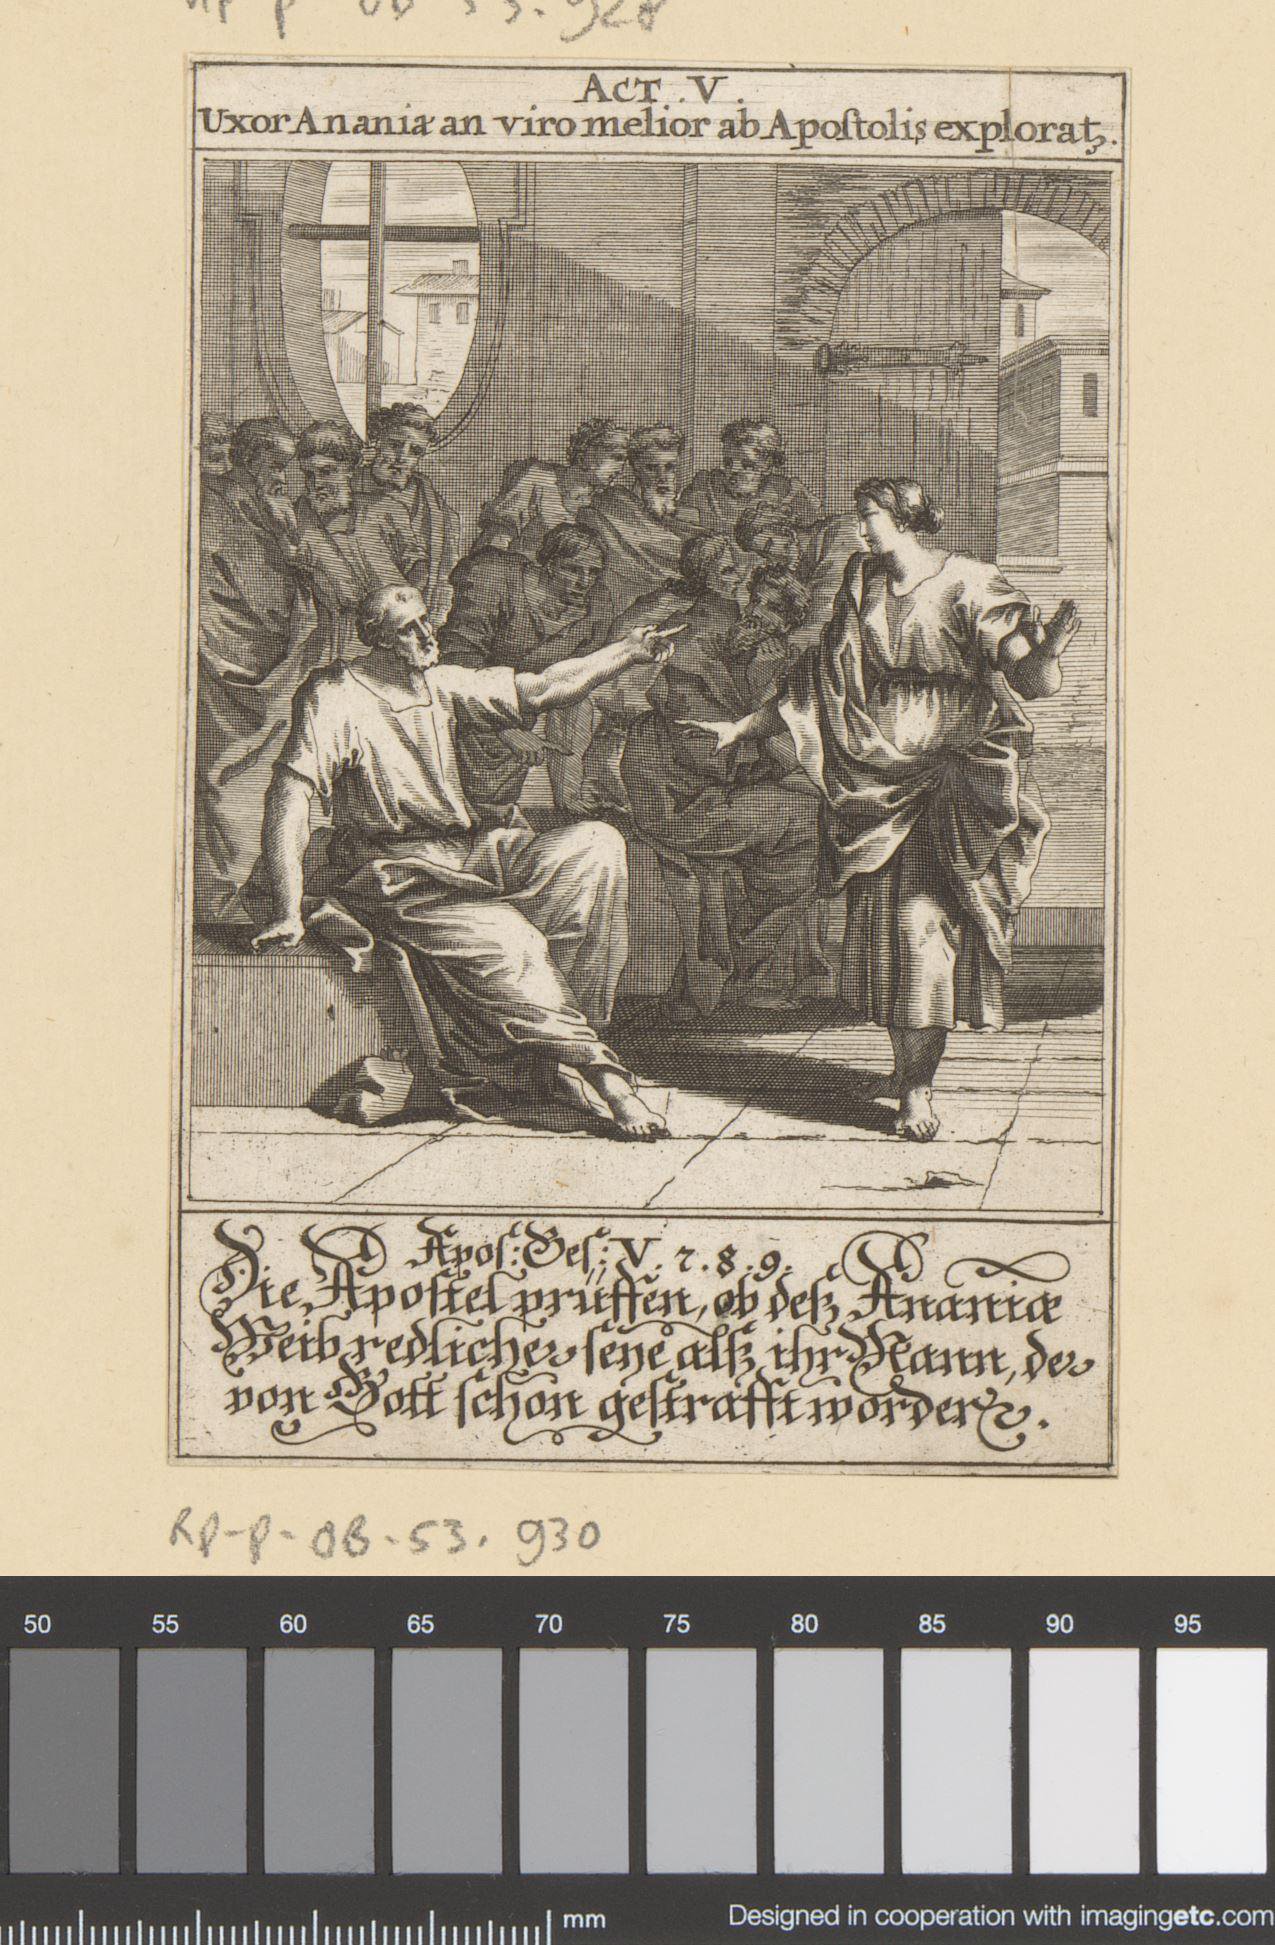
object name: print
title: Saffira wordt door de apostelen op de proef gesteld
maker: Anonymous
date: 1697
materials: paper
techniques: etching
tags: peter questioning sapphira, who then dies too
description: Prent ook gebruikt in: Biblia ectypa : Bildnussen auss Heiliger Schrifft. Regensburg: Chr. Wiegel, 1697.